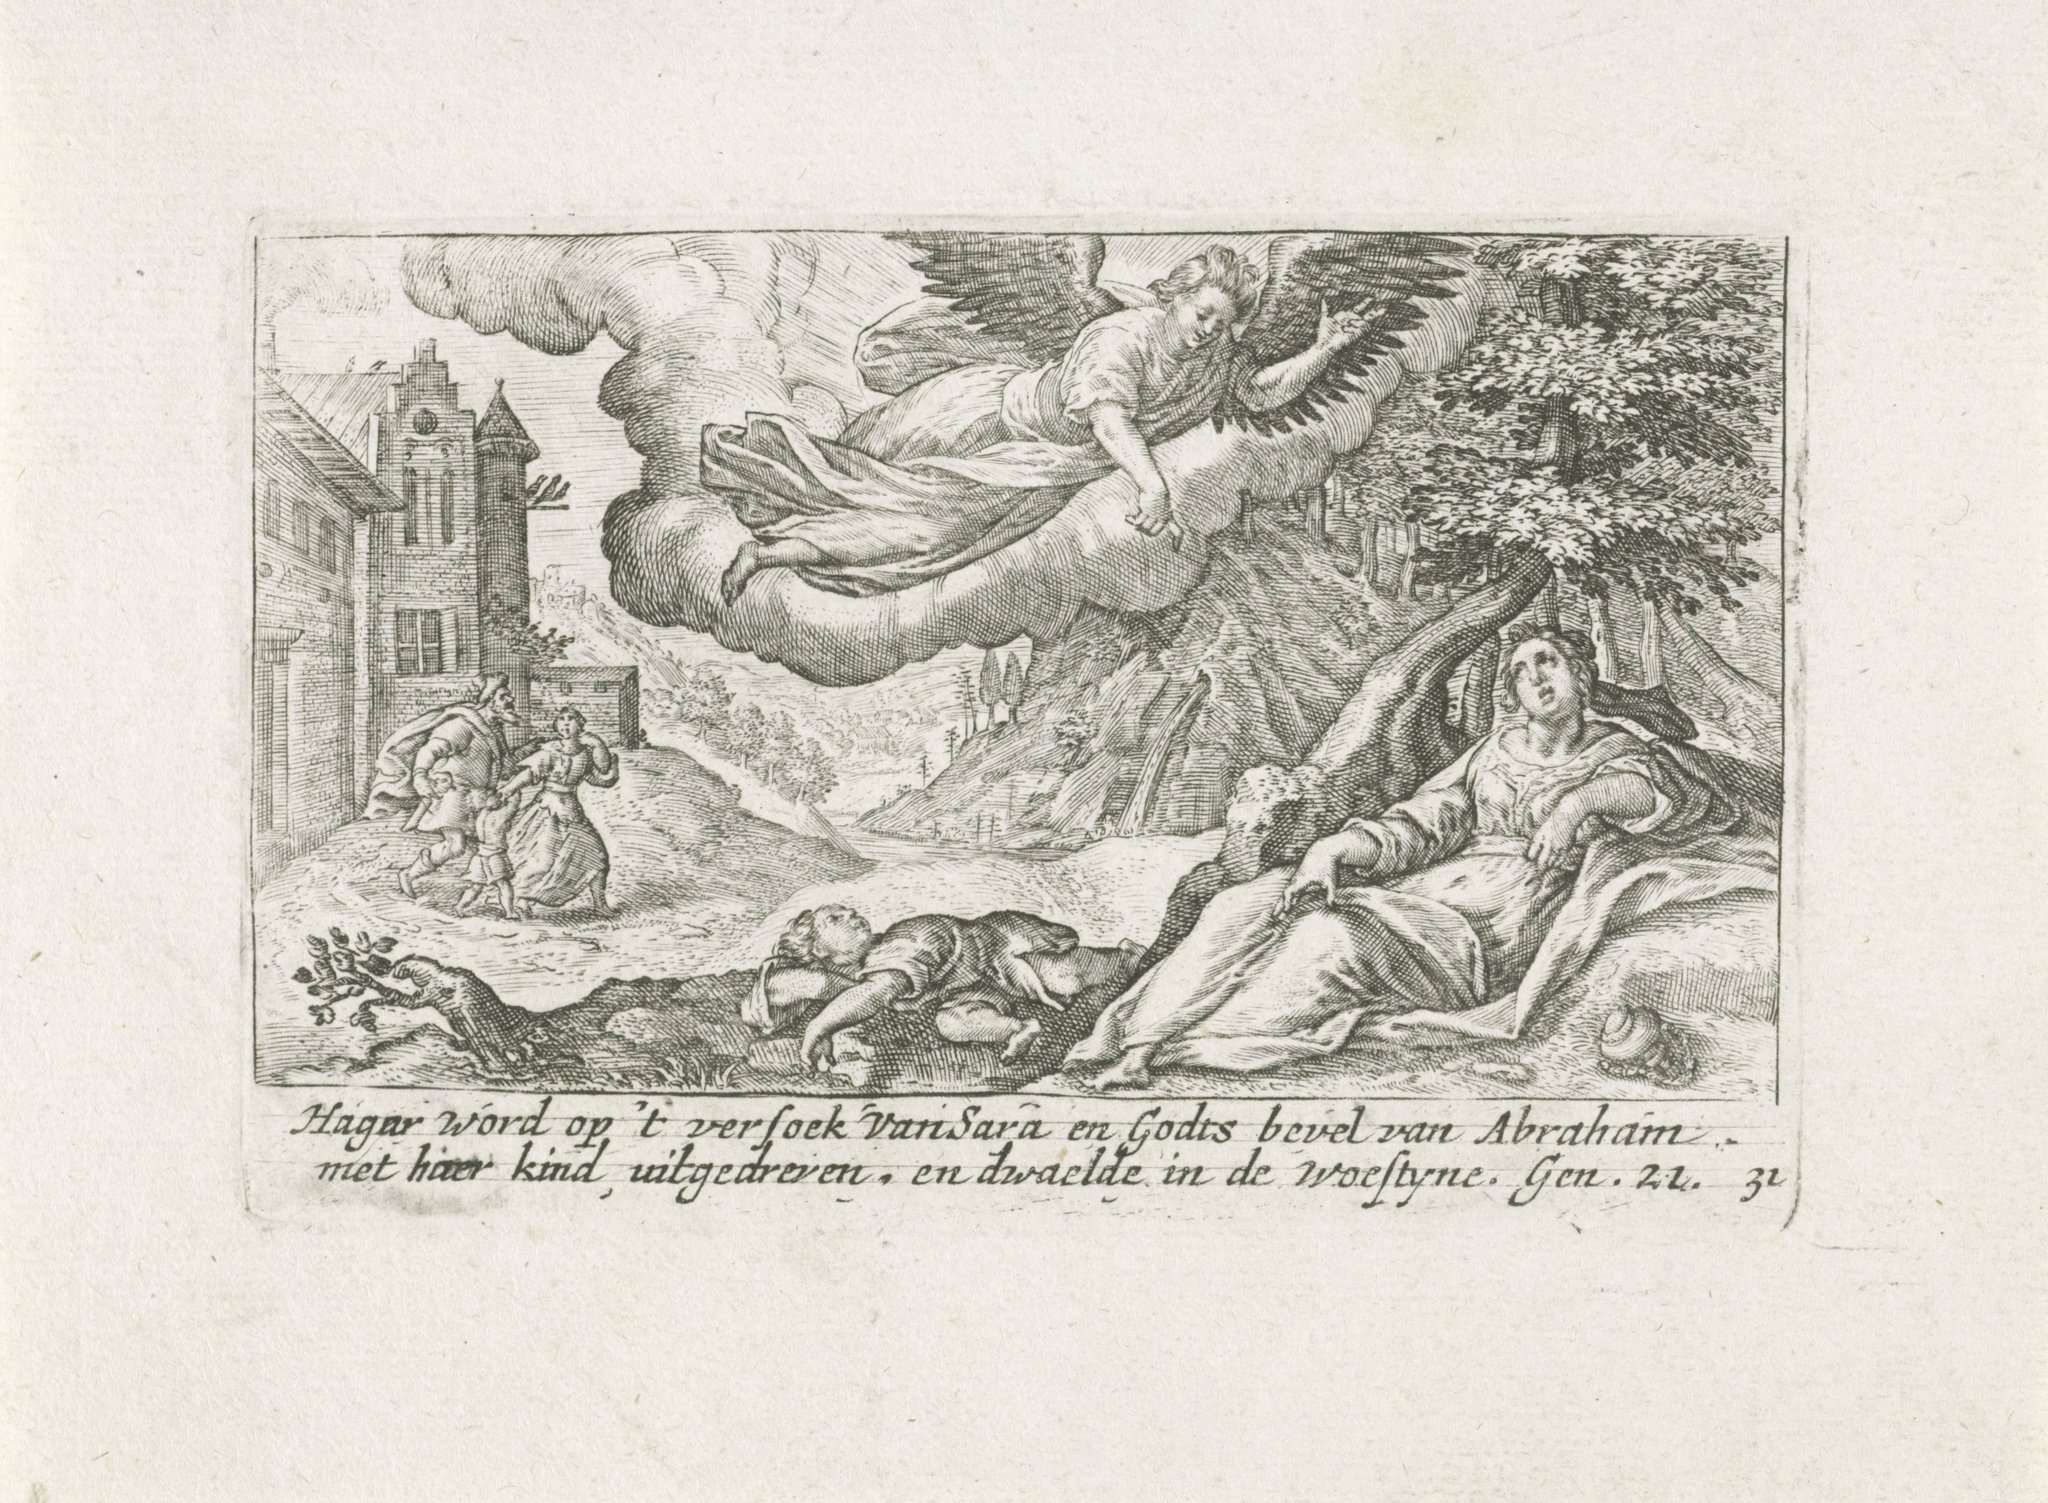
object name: print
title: De engel wijst Hagar een bron in de woestijn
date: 1700-1750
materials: paper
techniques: engraving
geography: utrecht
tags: abraham provides hagar and ishmael with bread and a jug of water, an angel appears and reveals a well of water to hagar, hagar sits weeping after having put ishmael under a bush to die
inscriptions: collector's mark: Lugt 2233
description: Abraham stuurt Hagar en Ismaël weg naar de woestijn. Als het water opraakt legt Hagar haar zoon onder een struik om te sterven. Een engel verschijnt en wijst haar een bron, zodat beiden gered worden. In de marge een tweeregelig onderschrift in het Nederlands.